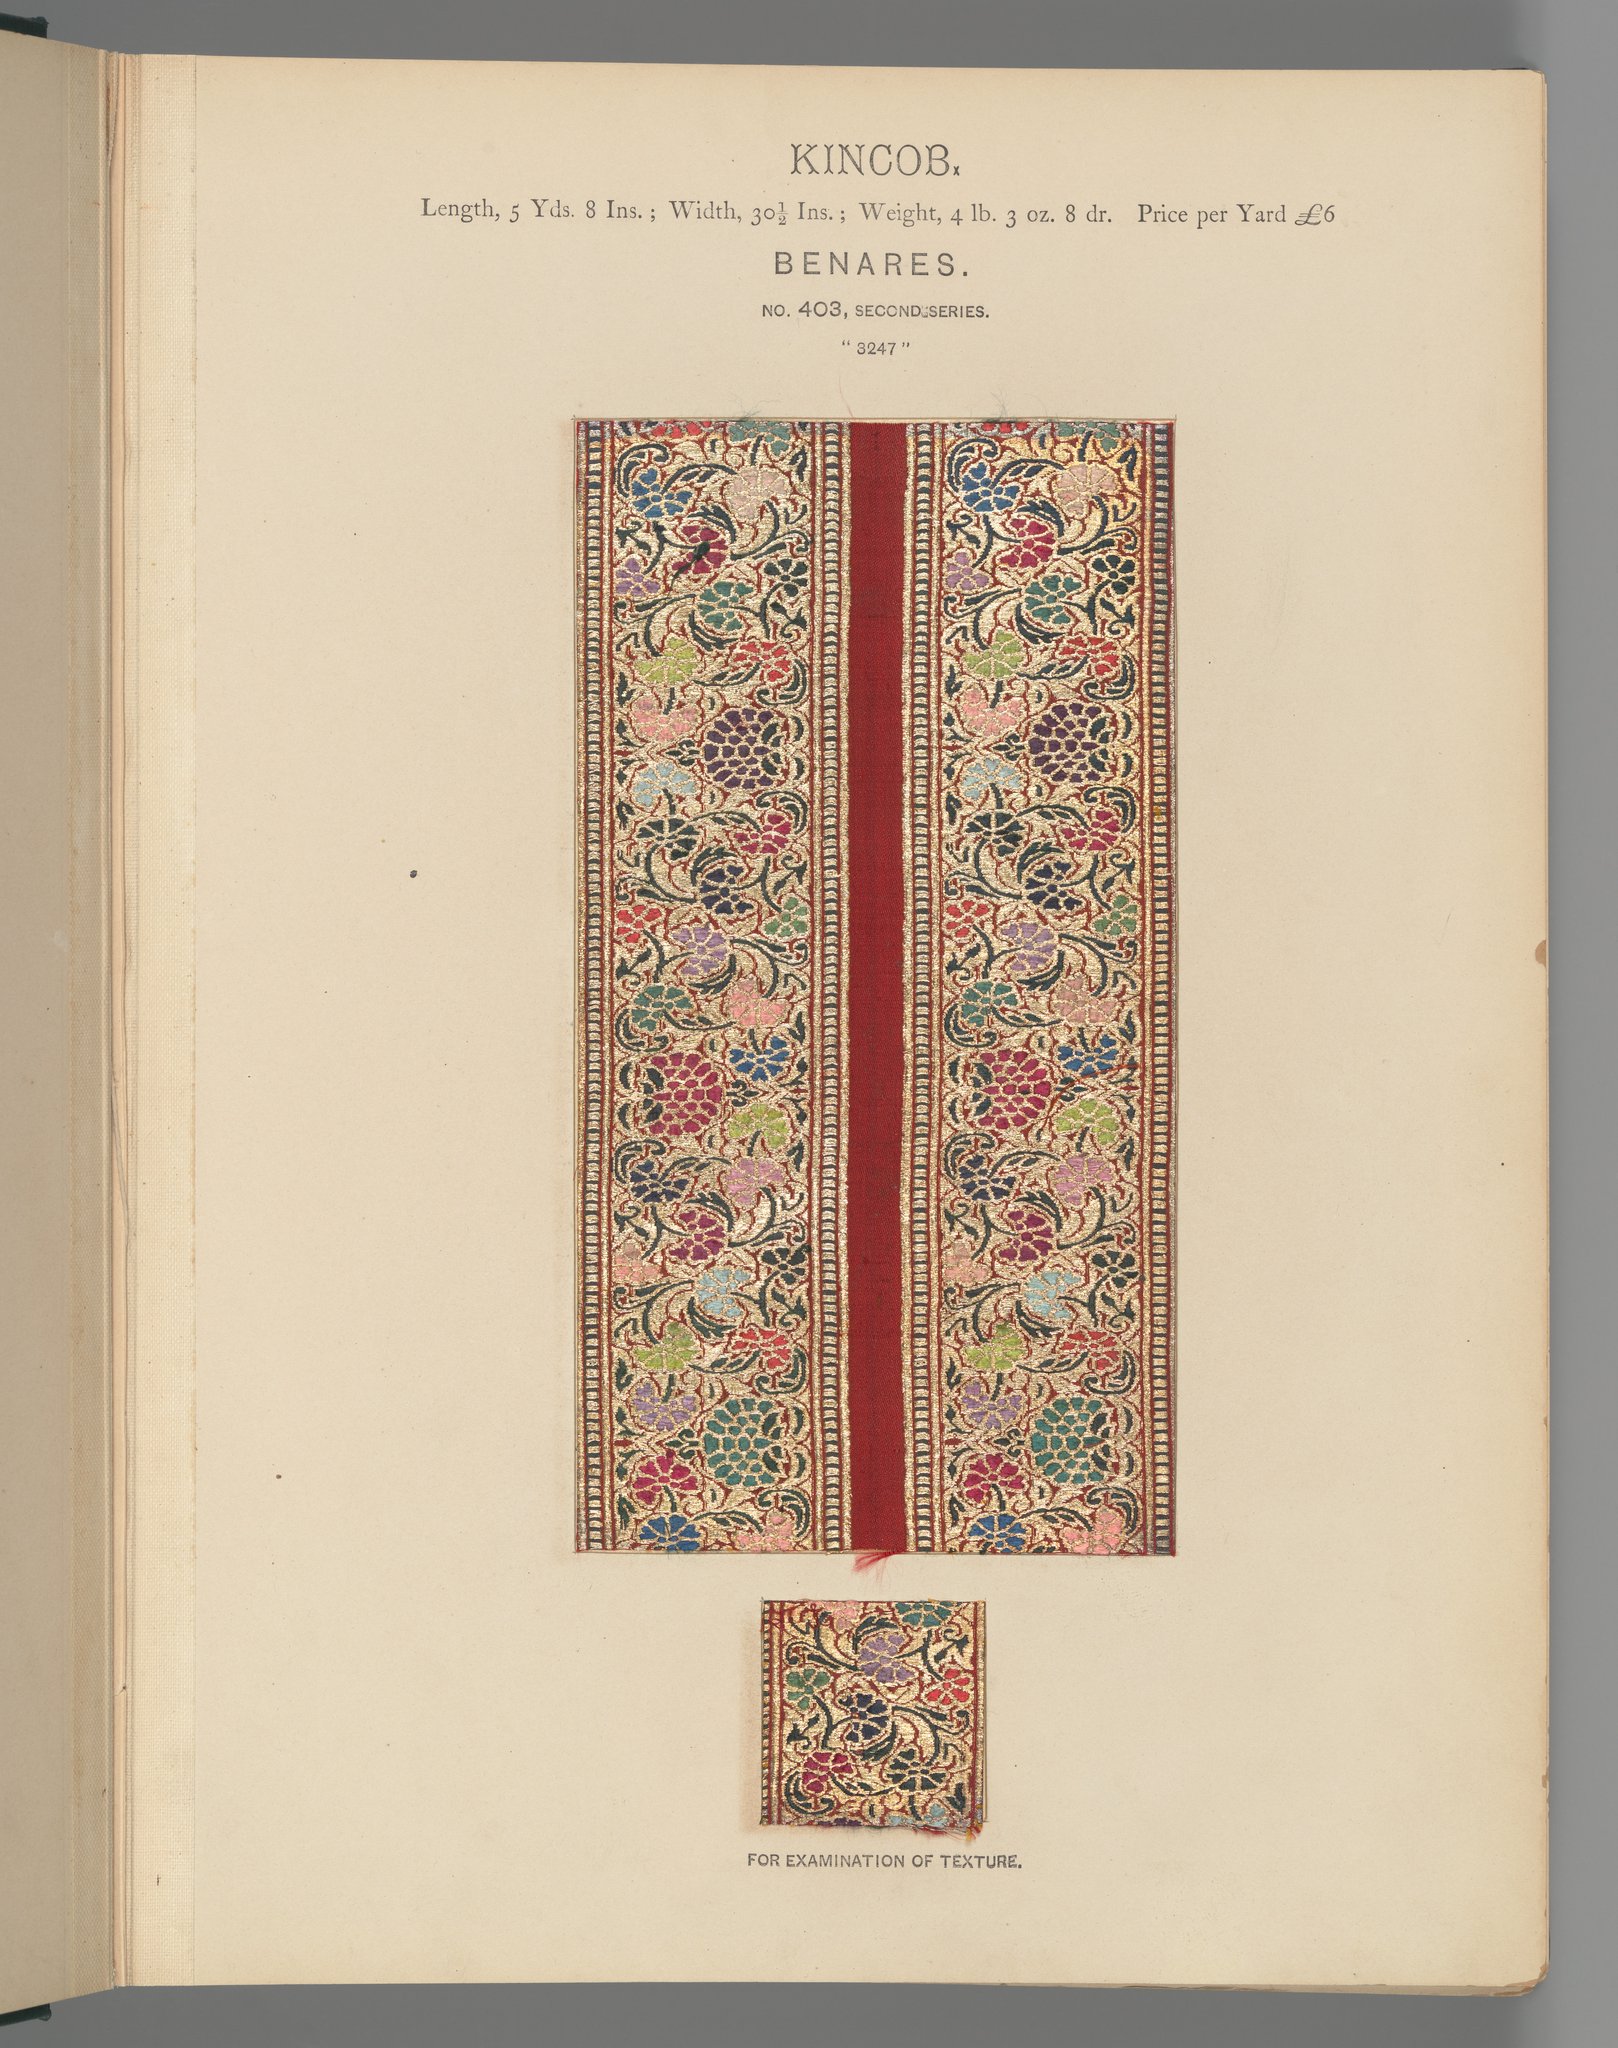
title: Collection of specimens and illustrations of the textile manufactures of India. Second series : Kincobs, Nos. 401 to 458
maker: john forbes watson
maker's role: editor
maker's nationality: scottish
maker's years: 1827-1892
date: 1873-1880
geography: england